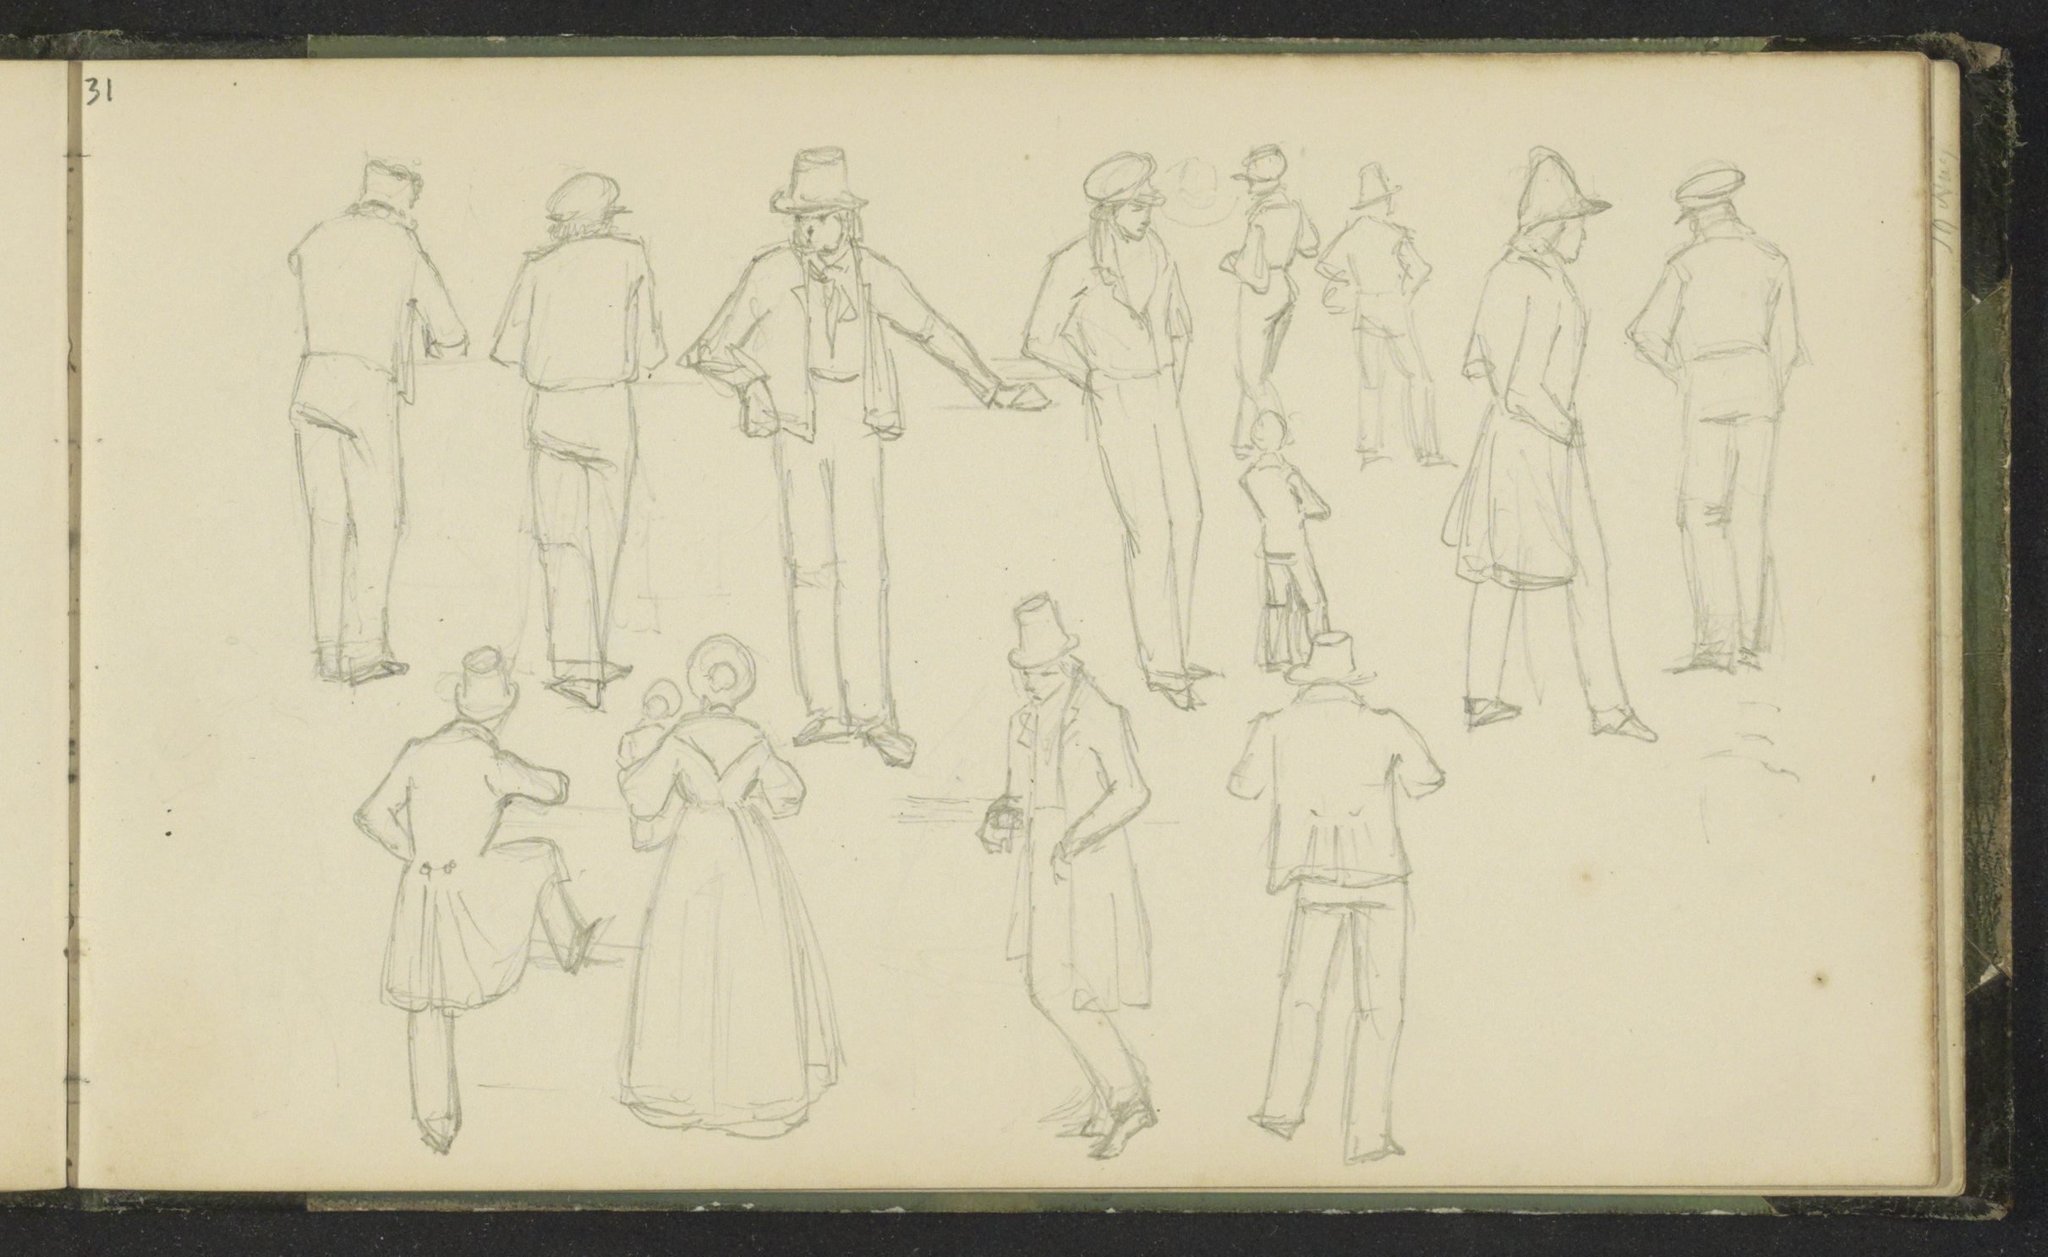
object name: sketchbook leaf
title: Studieblad met staande mannen met hoofddeksels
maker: hendrik abraham klinkhamer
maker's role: draughtsman, painter, print maker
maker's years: 1810-1872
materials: paper, pencil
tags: standing figure, head-gear: hat (+ men's clothes)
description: Tussen de mannen staat één vrouw met een hoed. Blad 31 recto uit een schetsboek met 40 bladen.